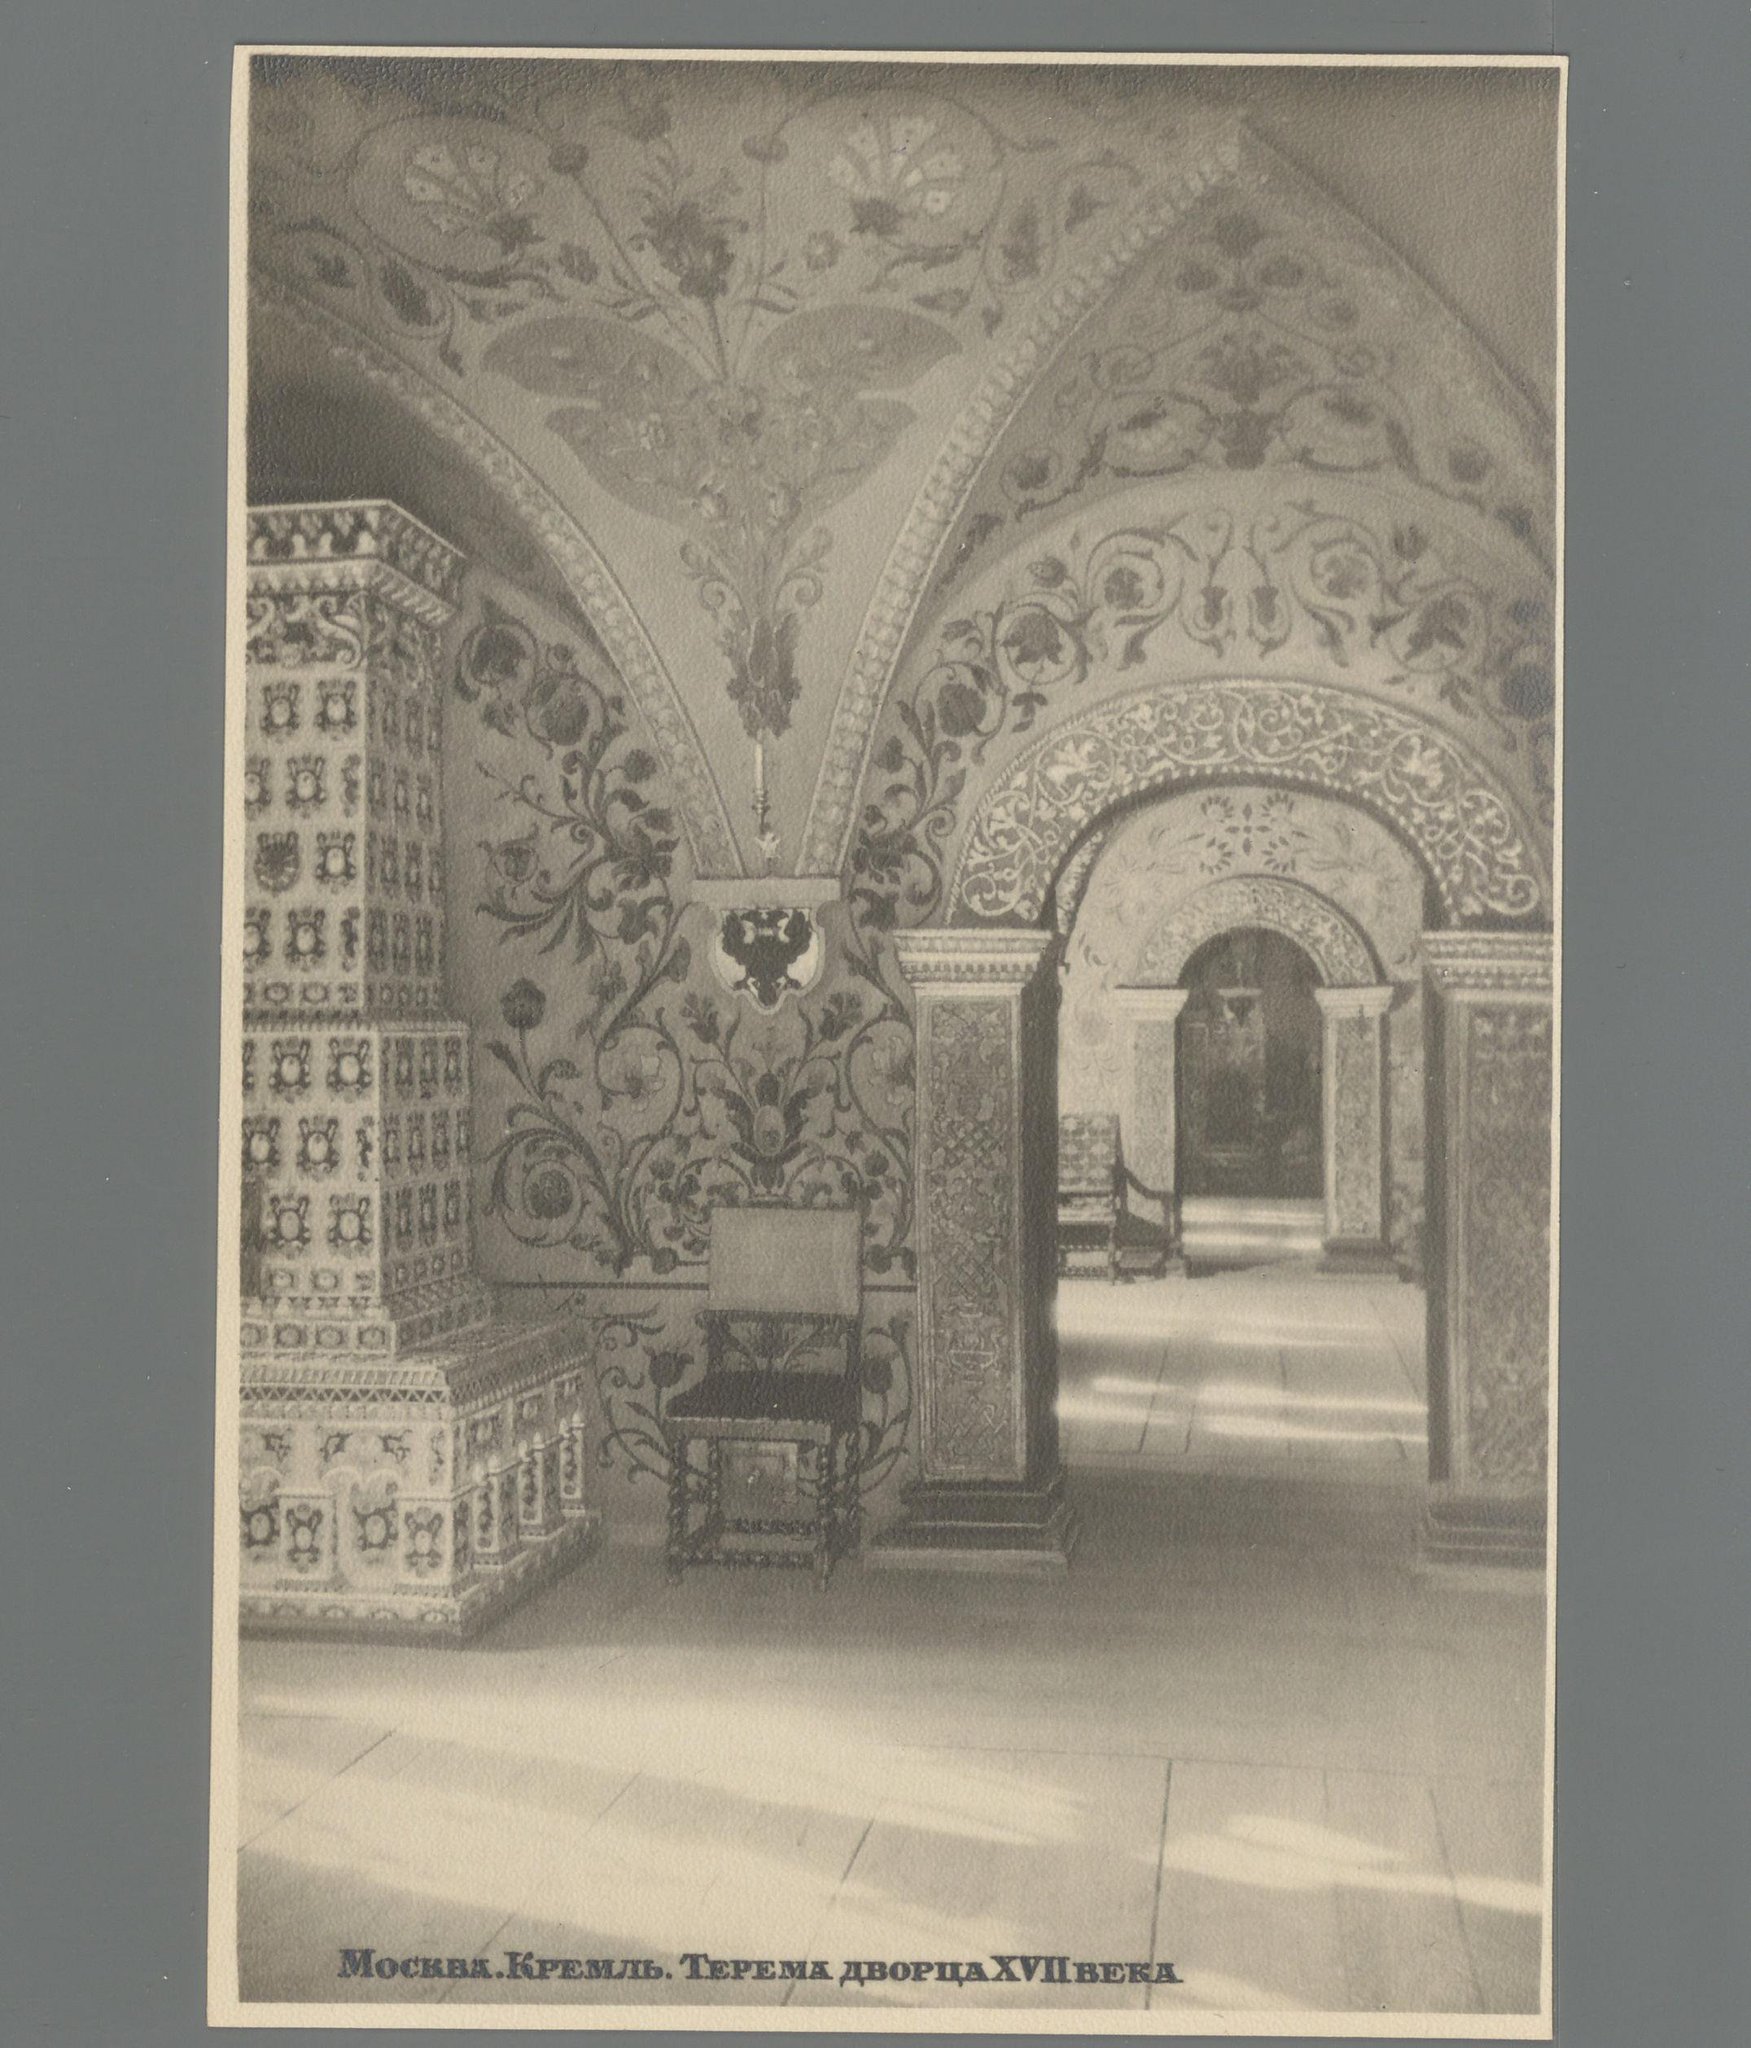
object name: ansichtkaart, prentbriefkaart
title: Interieur van een huis in het Kremlin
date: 1954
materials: paper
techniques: gelatin silver print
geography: moscow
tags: interior of the house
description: De titel op object staat in het Russisch.